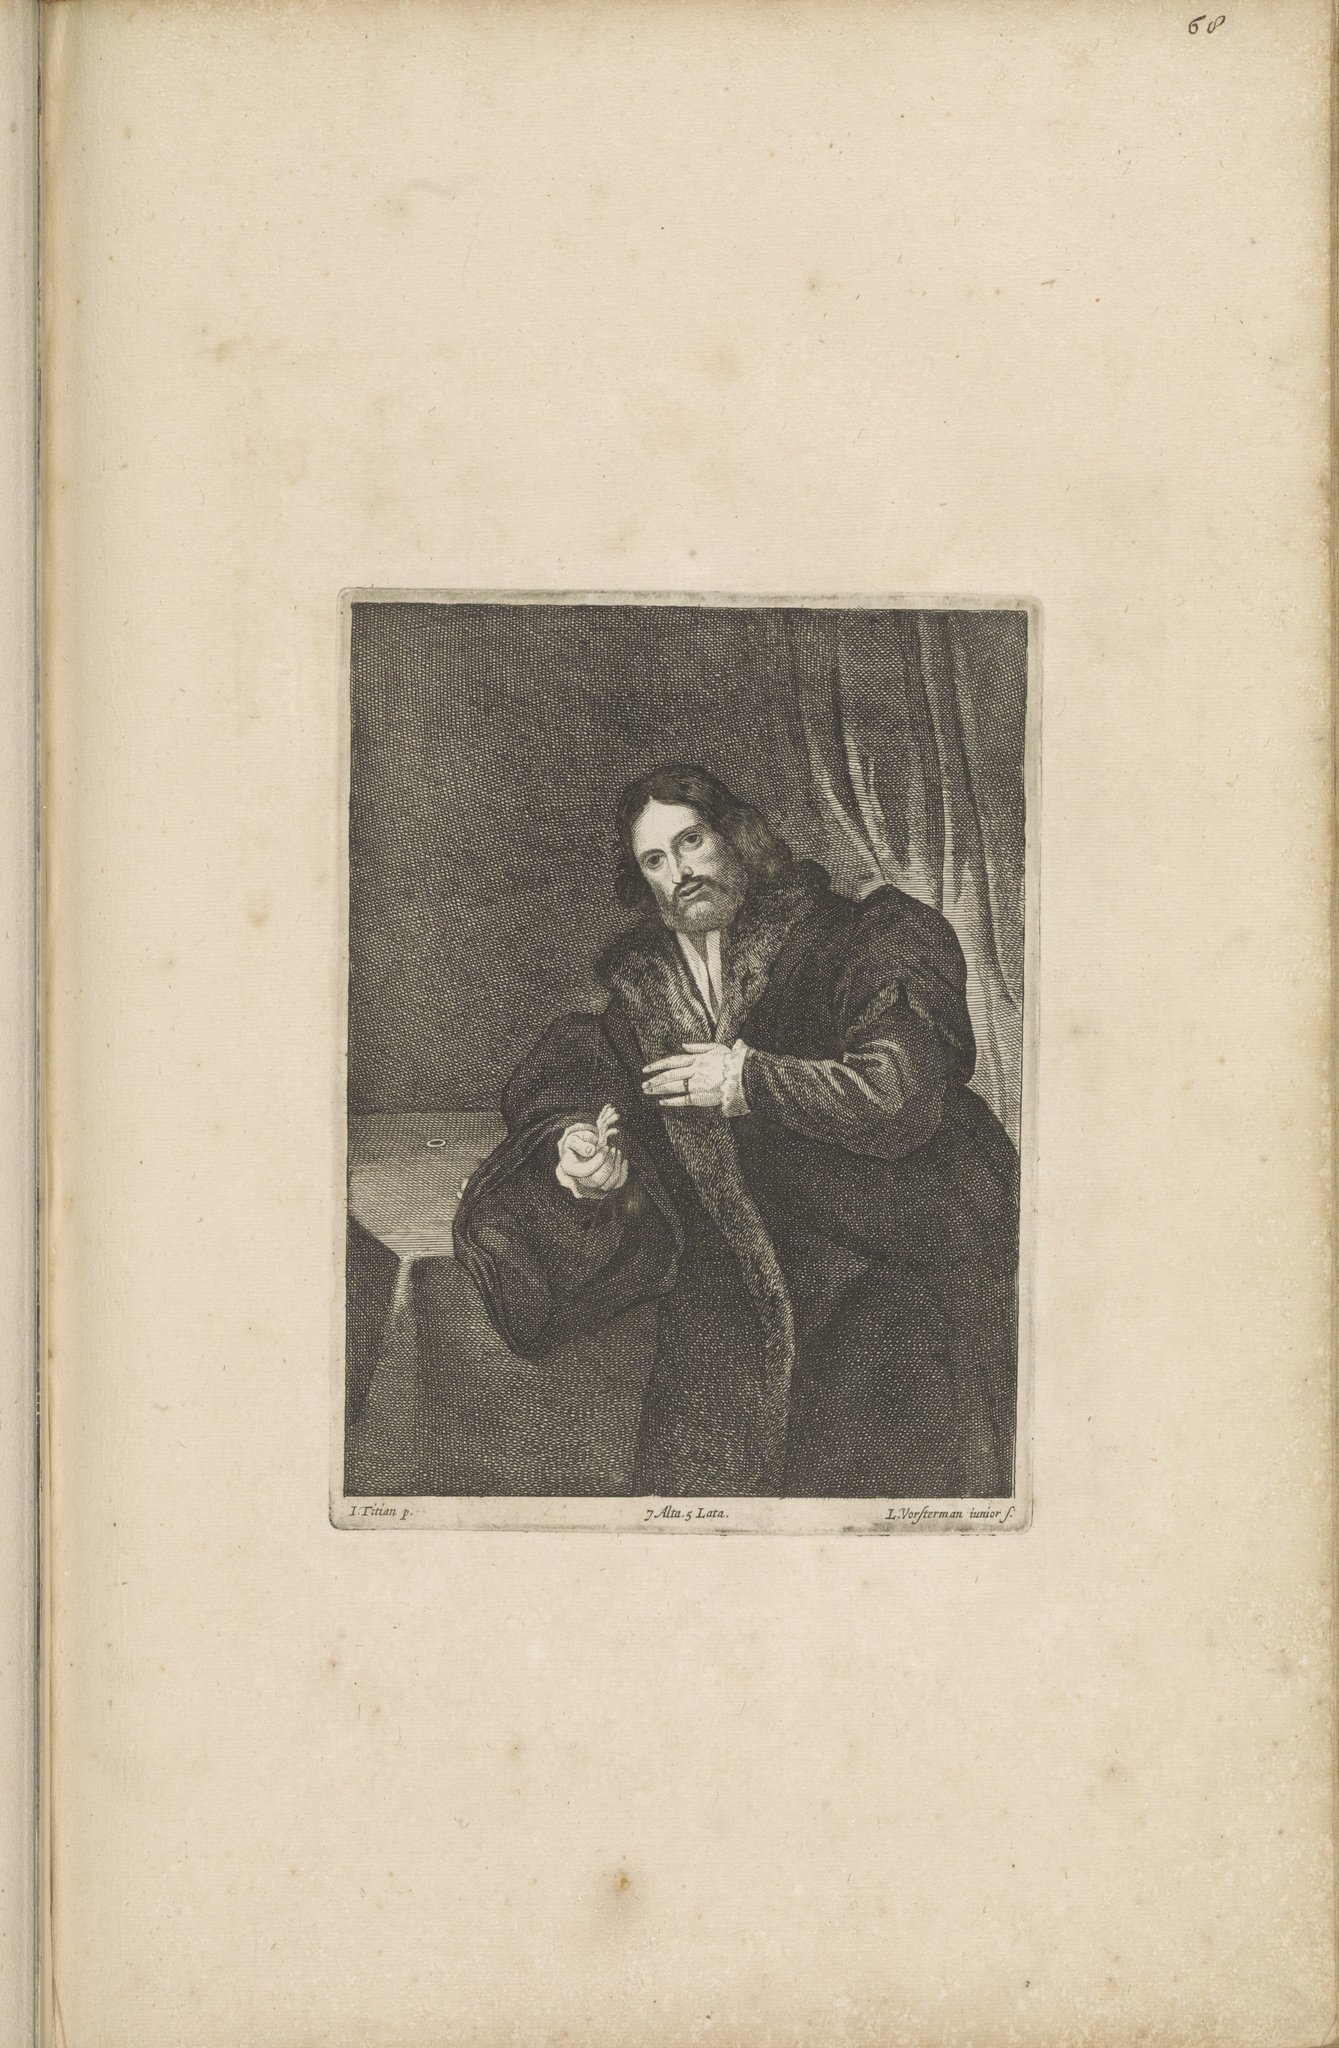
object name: print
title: Portret van een man met een gouden klauw, mogelijk Leonino Brembate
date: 1660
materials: paper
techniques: etching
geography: brussels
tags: historical persons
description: De prent is vervaardigd naar het schilderij van Lotto dat zich in de collectie van het Kunsthistorisches Museum te Wenen bevindt (inventarisnummer GG_265). David Teniers heeft waarschijnlijk van alle schilderijen uit de collectie van Leopold Willem van Oostenrijk een olieverfstudie op doek of paneel vervaardigd (zgn. pasticcio), die als voorbeeld voor de prentmakers diende. Het is niet altijd duidelijk of de pasticci door hem zijn gemaakt of door zijn atelier. Niet alle pasticci zijn overgeleverd.